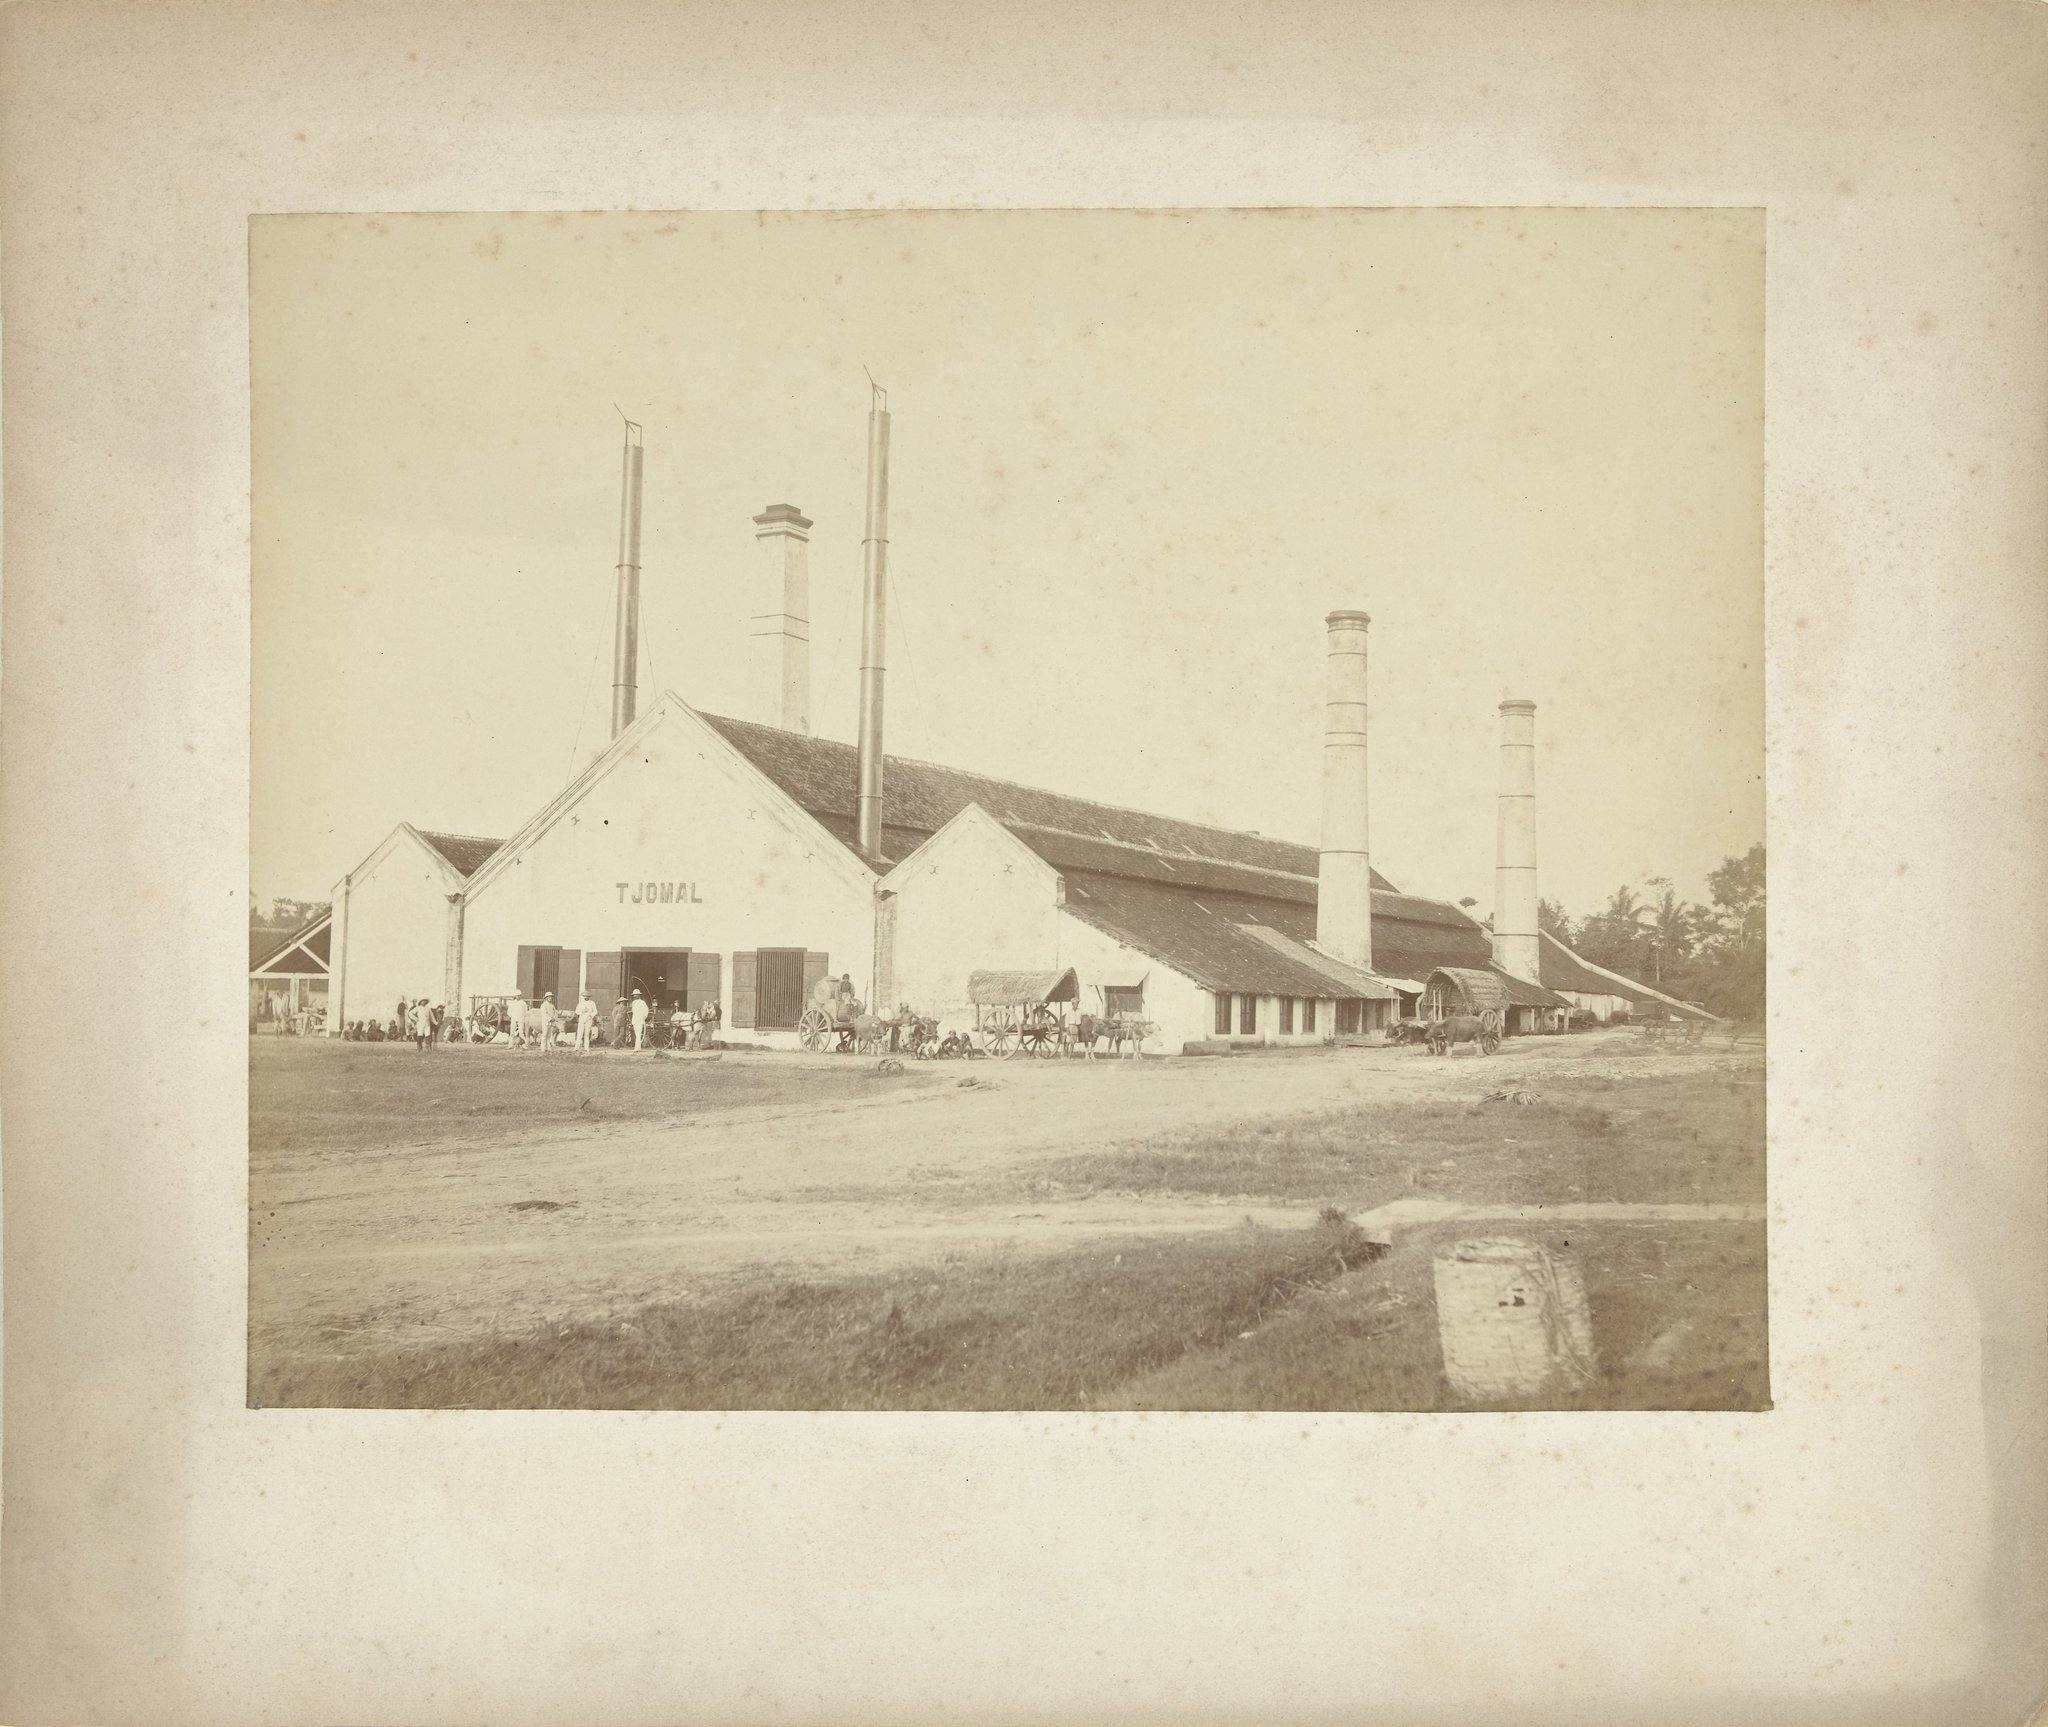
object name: photograph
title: Fabrieksgebouw van suikerfabriek Tjomal op Java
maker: Anonymous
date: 1870-1900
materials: cardboard, paper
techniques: albumen print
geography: java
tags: factory-building, java